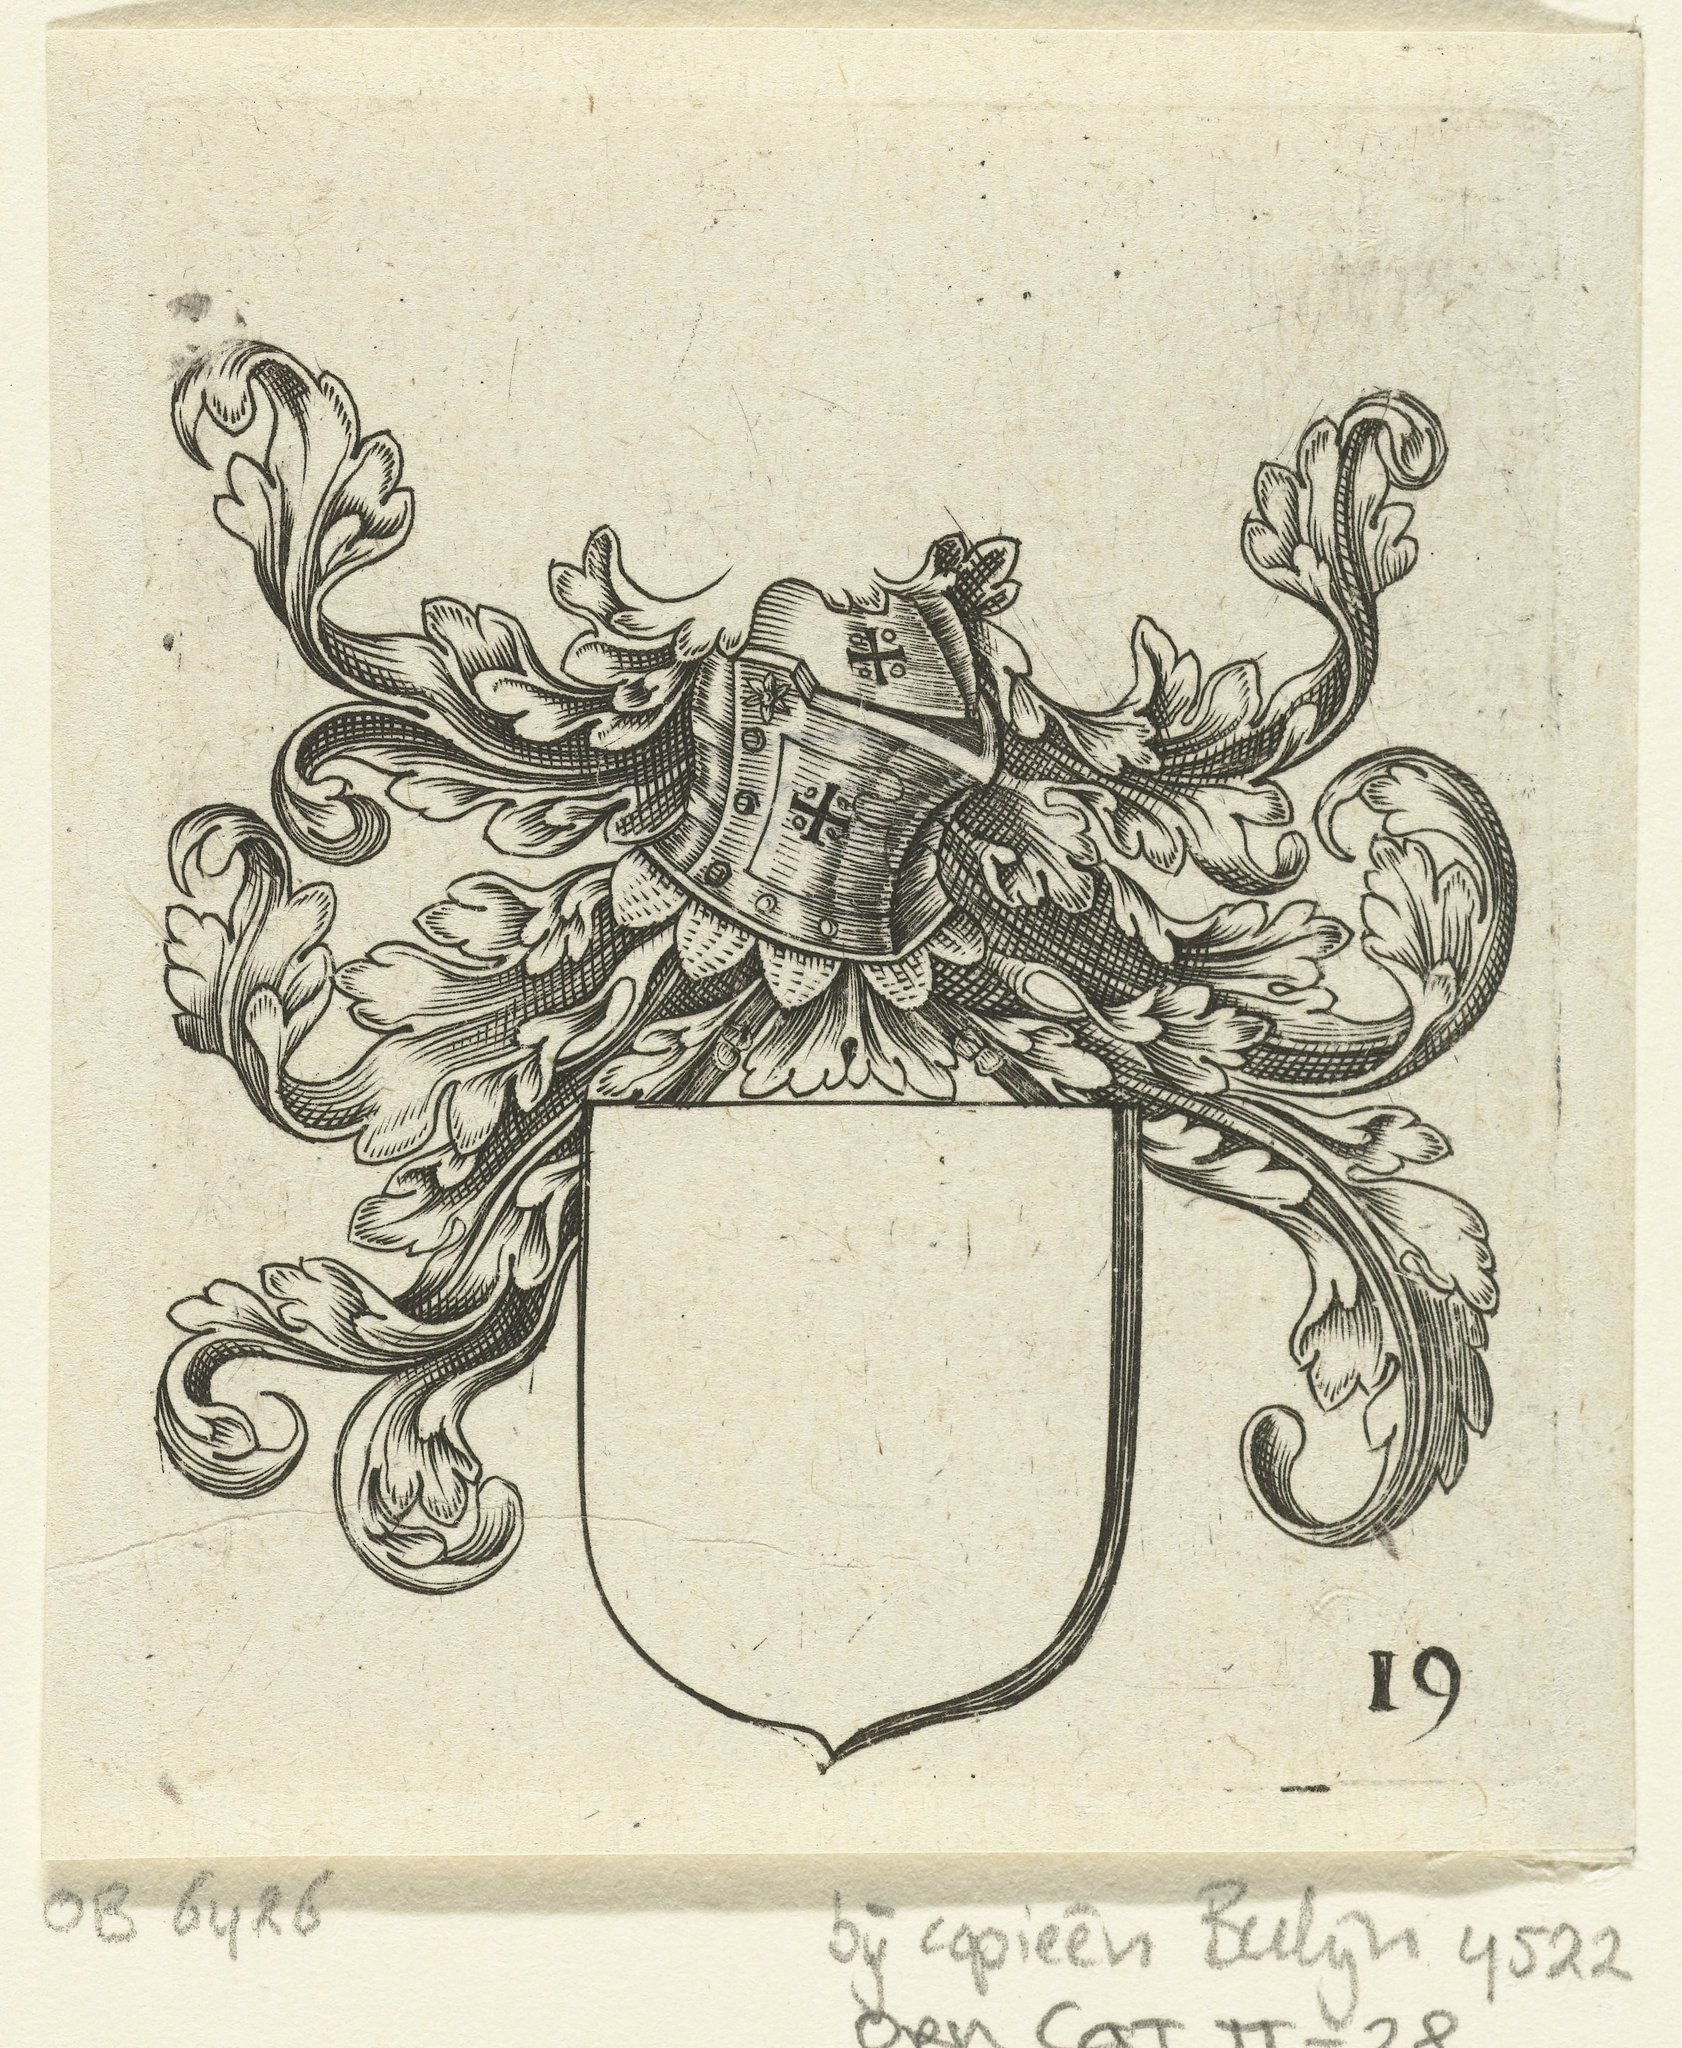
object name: print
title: Wapenschild met helm en bladranken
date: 1625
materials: paper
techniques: engraving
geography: amsterdam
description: De helm wijst naar rechts. Aan beide kanten van de helm bevinden zich drie bladranken. Blad uit serie wapenschilden met lege compartimenten.